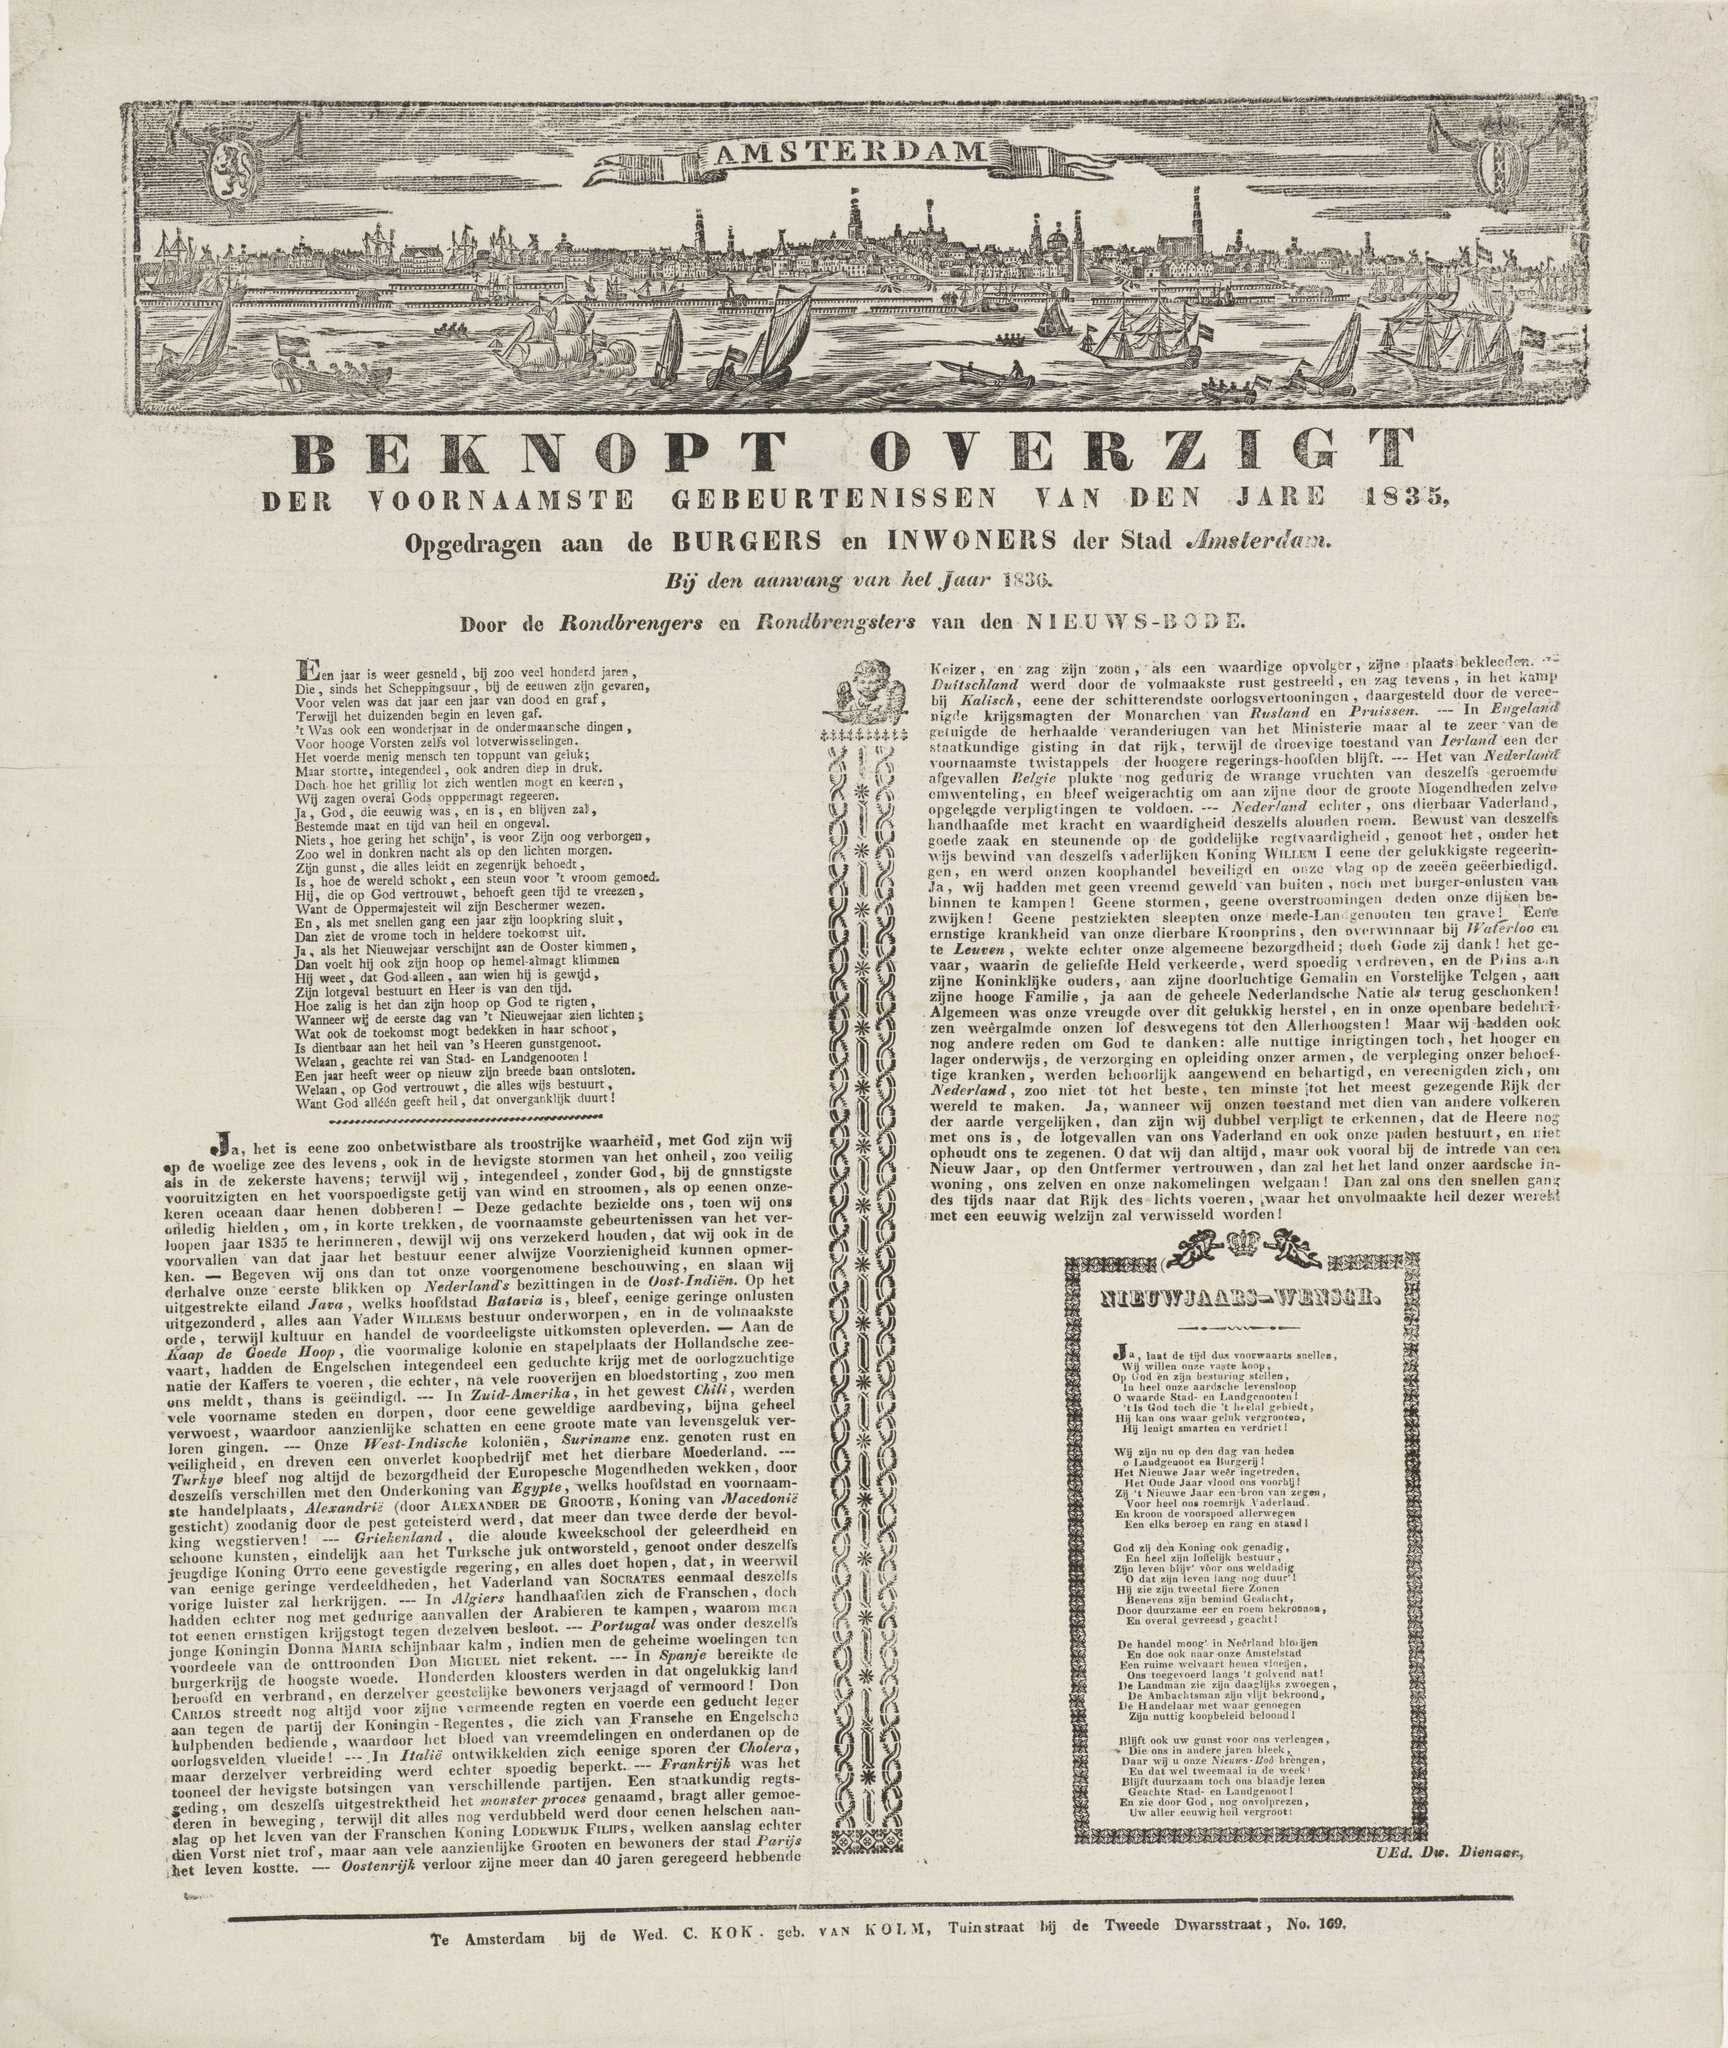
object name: print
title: Nieuwjaarswens van de Amsterdamse courantombrengers voor het jaar 1836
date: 1835-1836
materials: paper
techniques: letterpress printing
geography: amsterdam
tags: street, amsterdam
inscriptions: collector's mark: Lugt 2228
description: Nieuwjaarswens namens de ombrengers van couranten (krantenbezorgers) te Amsterdam voor het jaar 1836. Bovenaan een gezicht op Amsterdam vanaf het IJ. Onderaan in twee kolommen het nieuws van het afgelopen jaar en twee verzen.